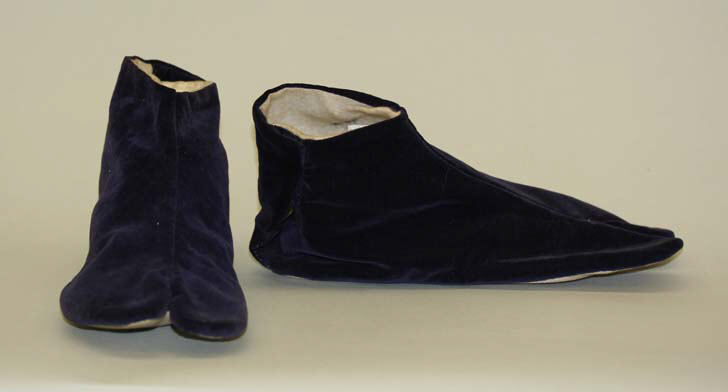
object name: tabi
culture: japanese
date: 1901-2000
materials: silk